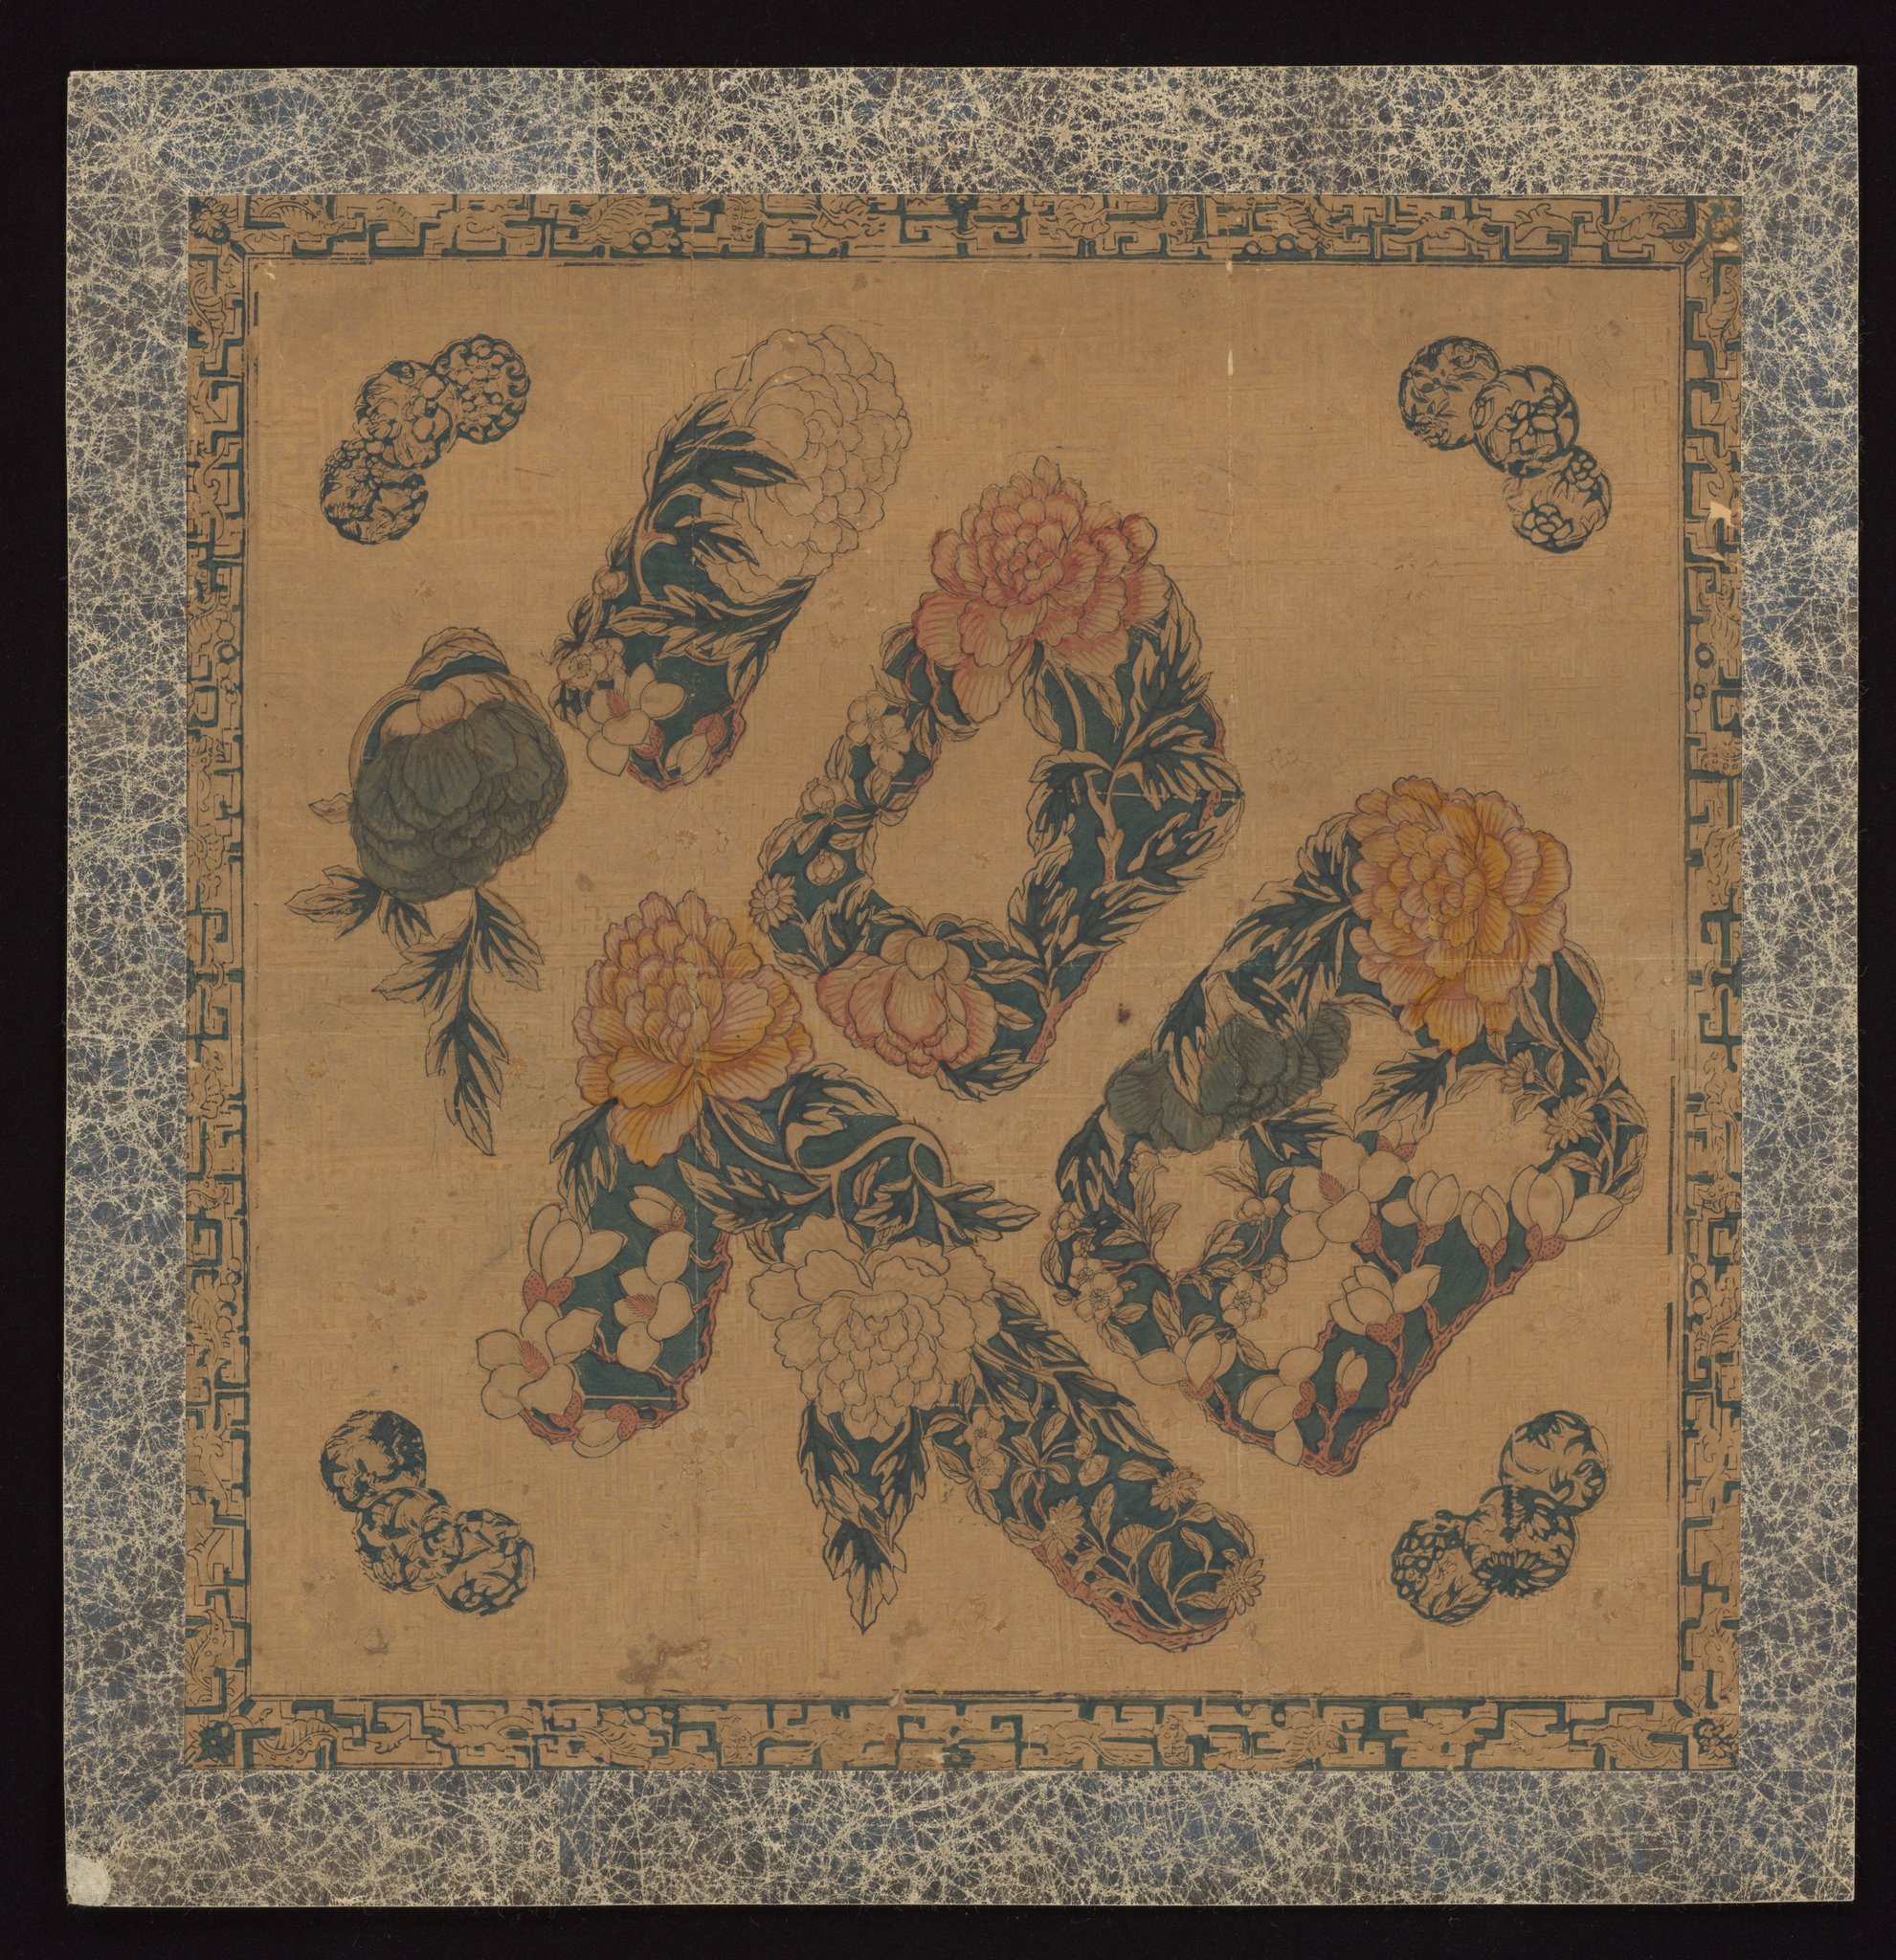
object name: print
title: The Character Fu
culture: chinese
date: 1736-1795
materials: ink, paper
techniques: hand coloring, woodblock print